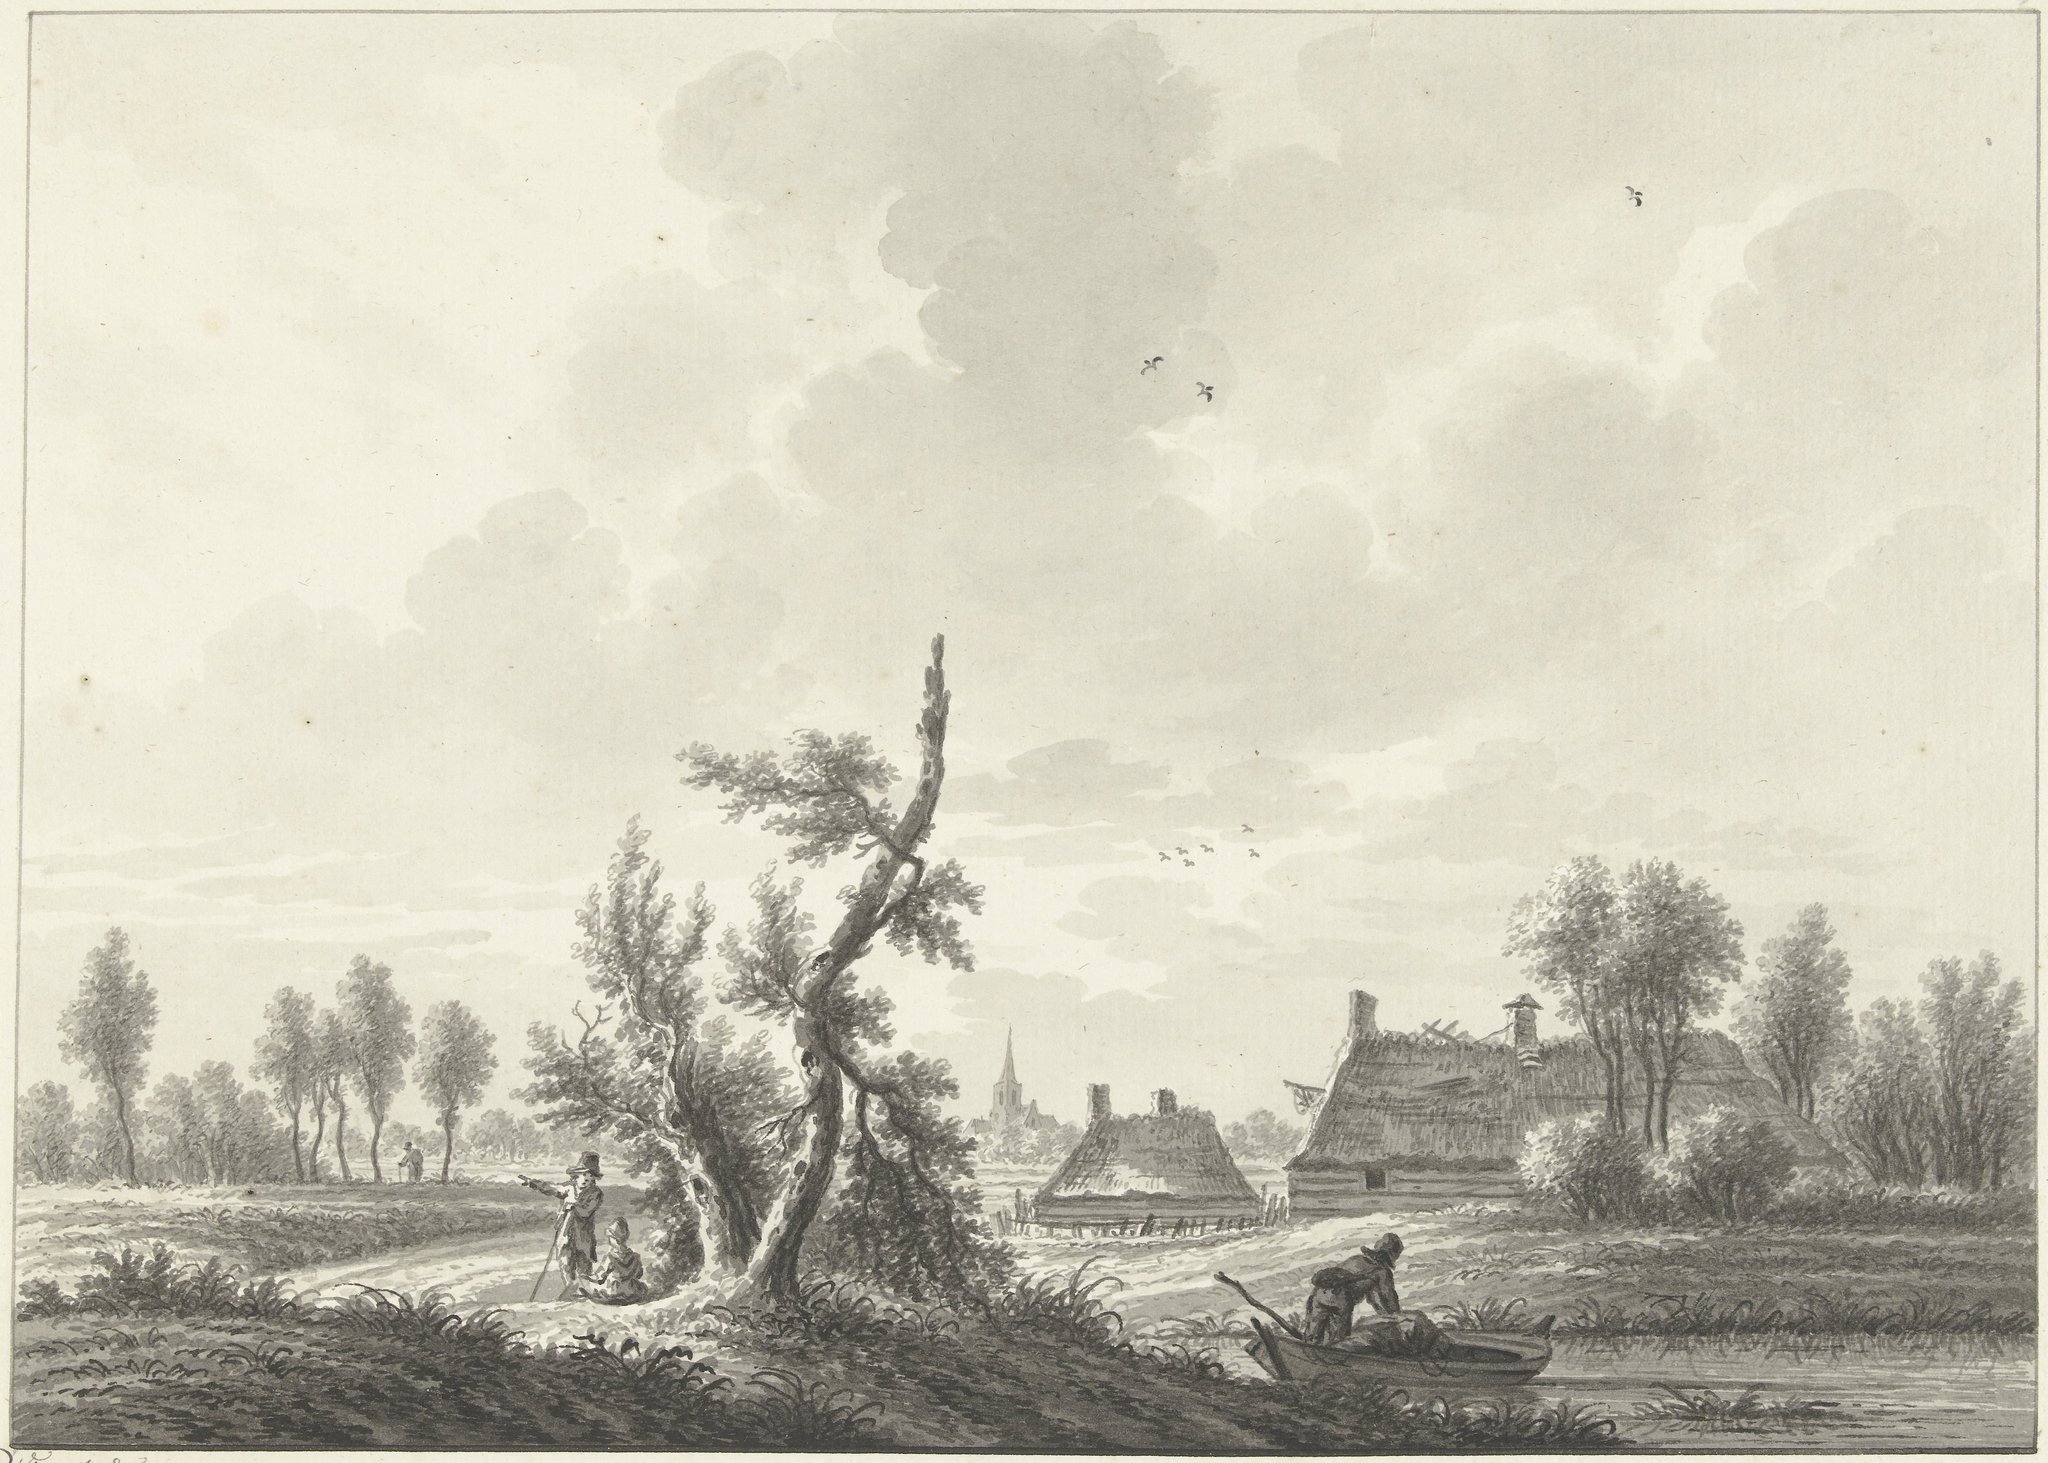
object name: drawing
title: Het dorp Laren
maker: nicolaas wicart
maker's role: draughtsman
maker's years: 1748-1815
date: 1758-1815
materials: ink, paper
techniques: brush, pen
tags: village, farm (building)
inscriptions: inscription: ‘'t Dorp Laaren’